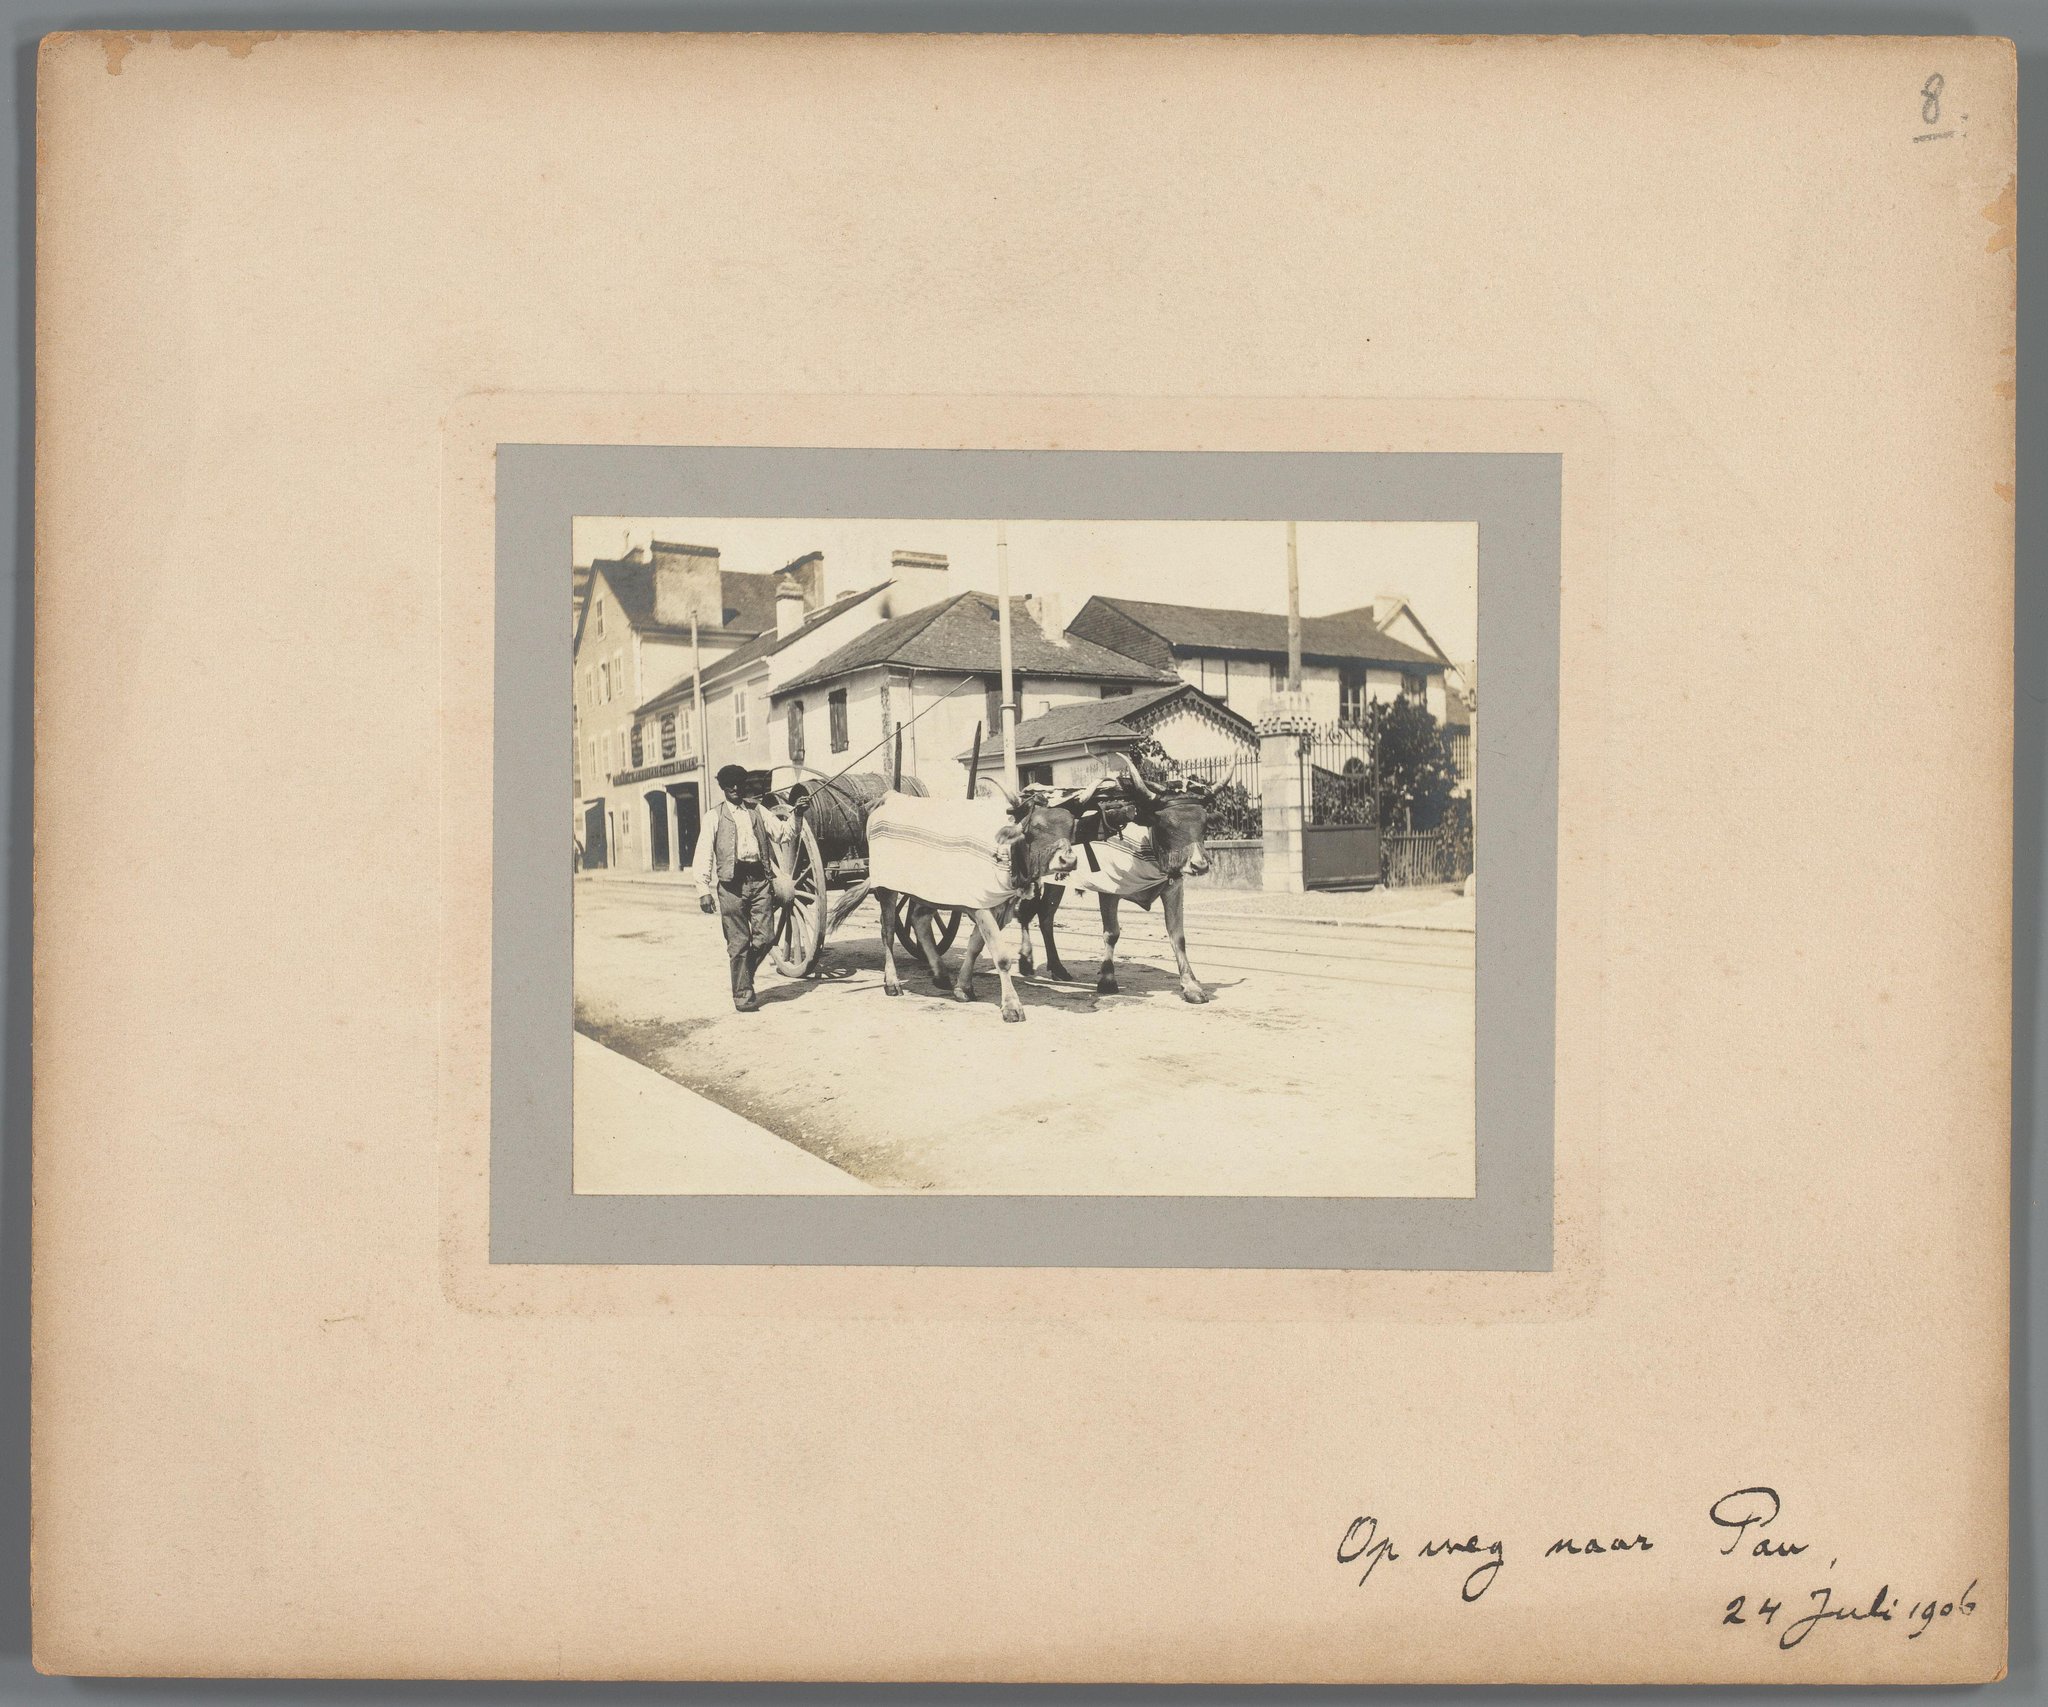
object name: photograph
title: Op weg naar Pau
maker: françois buys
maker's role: advocaat, amateurfotograaf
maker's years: 1871-1934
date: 1906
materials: paper, cardboard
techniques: gelatin silver print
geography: pau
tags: two-wheeled vehicle drawn by two animals, street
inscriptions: number: ‘8’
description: Deze foto maakt deel uit van een groep van 49 foto's.